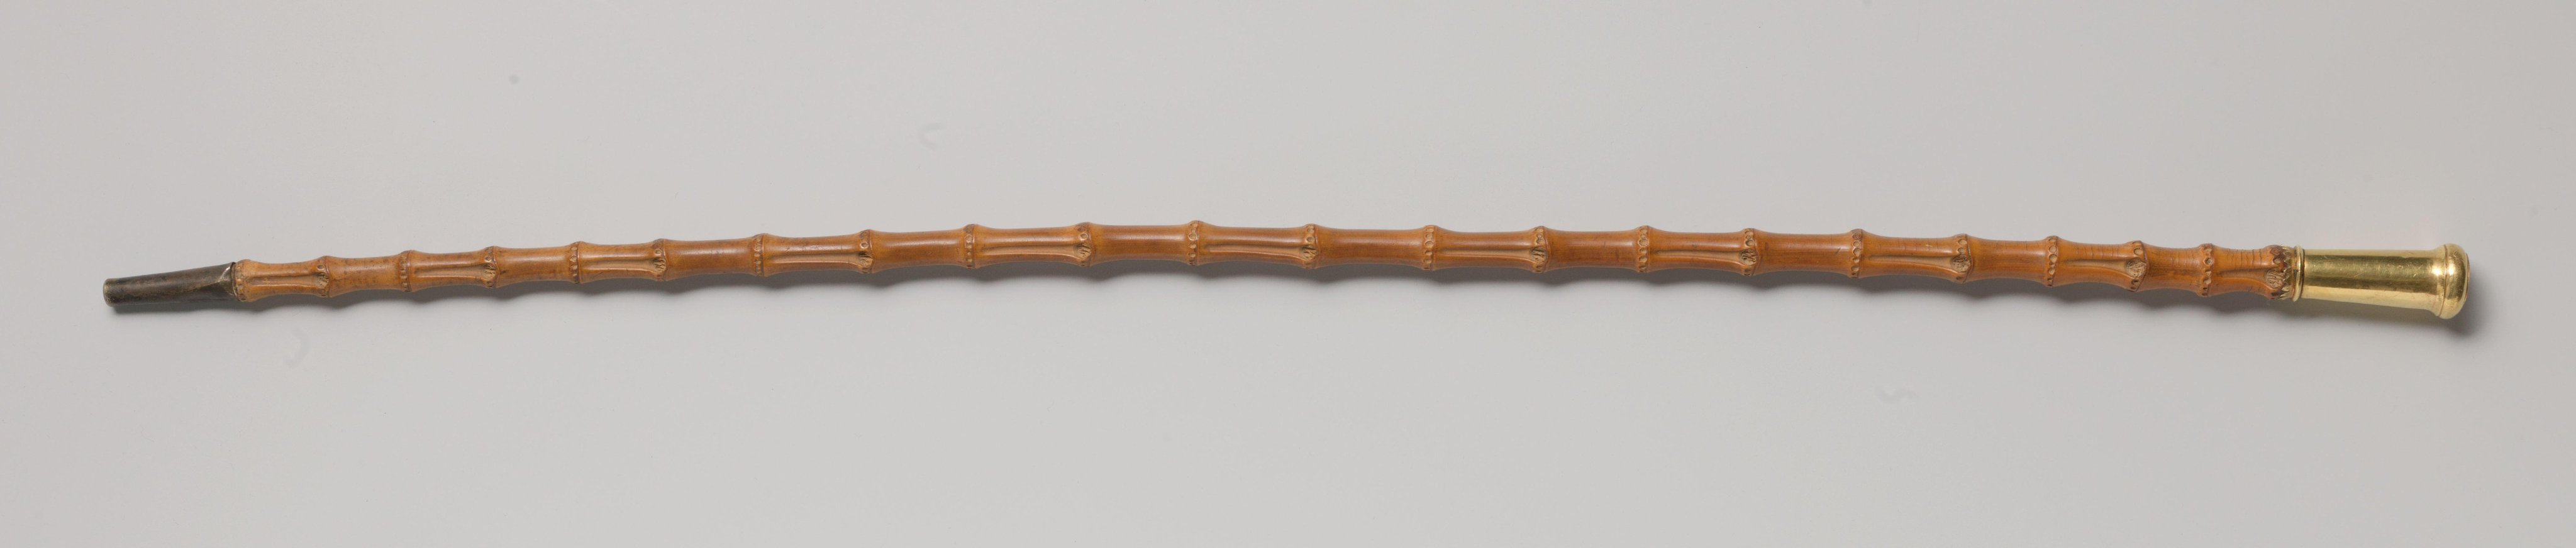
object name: rotting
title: Rotting met gouden VOC-munt van 1779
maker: Anonymous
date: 1779-1800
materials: gold, rattan, silver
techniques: cutting, gilding, striking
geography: indonesia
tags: indonesia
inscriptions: circumscription: ‘PAR CRES HOL C..CORDIA RES 1779’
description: Rotting met vergulde, zilveren knop bekroond met gouden VOC-munt waarop geharnaste man met in rechterhand een opgeheven zwaard en linkerhand een pijlenbundel met opschrift en datering. Onderkant rotting metalen voet.